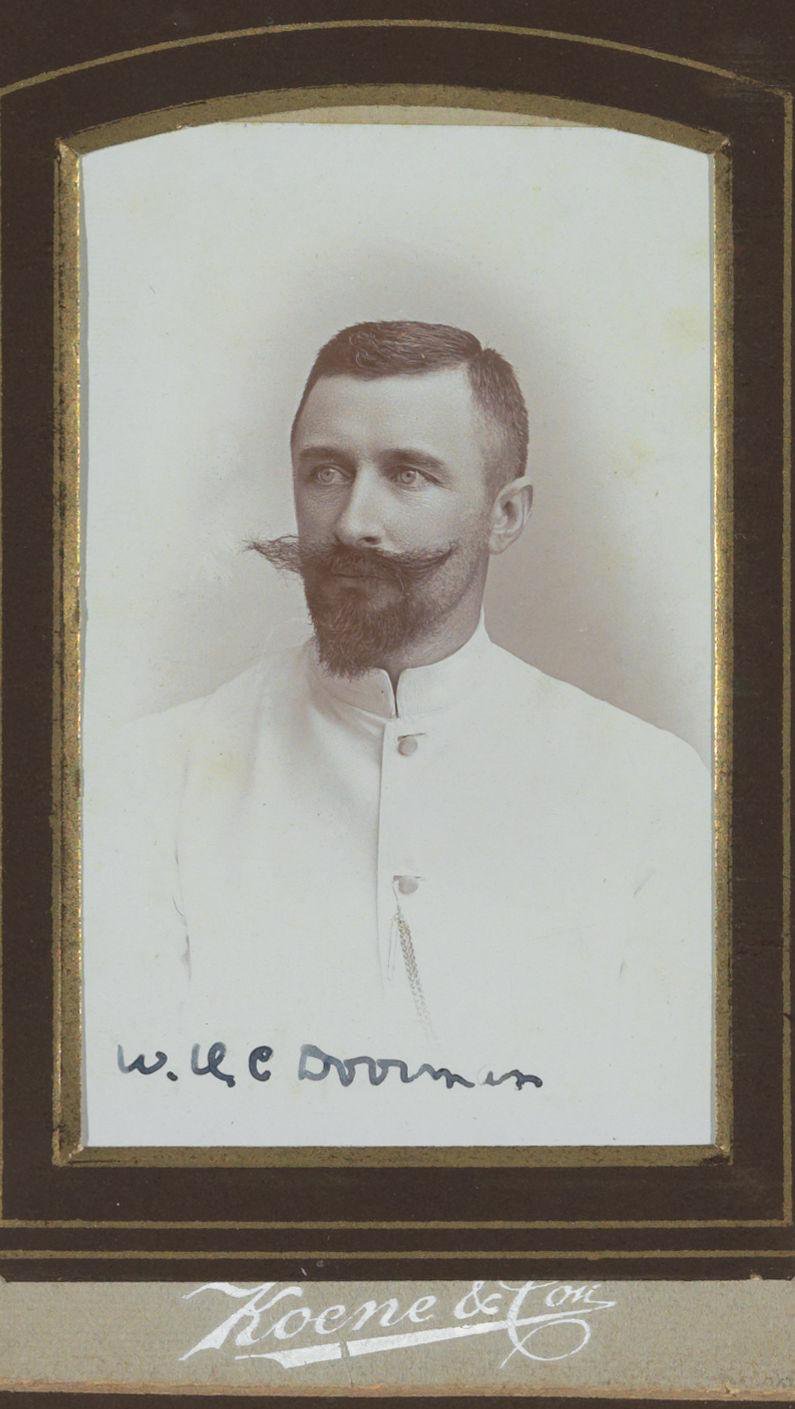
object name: photograph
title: Portret van W.[(...)].C. Doorman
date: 1890-1910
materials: cardboard, paper, photographic support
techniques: collodion silver print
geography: batavia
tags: adult woman, historical persons, batavia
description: Onderdeel van Fotoalbum van de families Matthes, Doorman en Van Thiel.